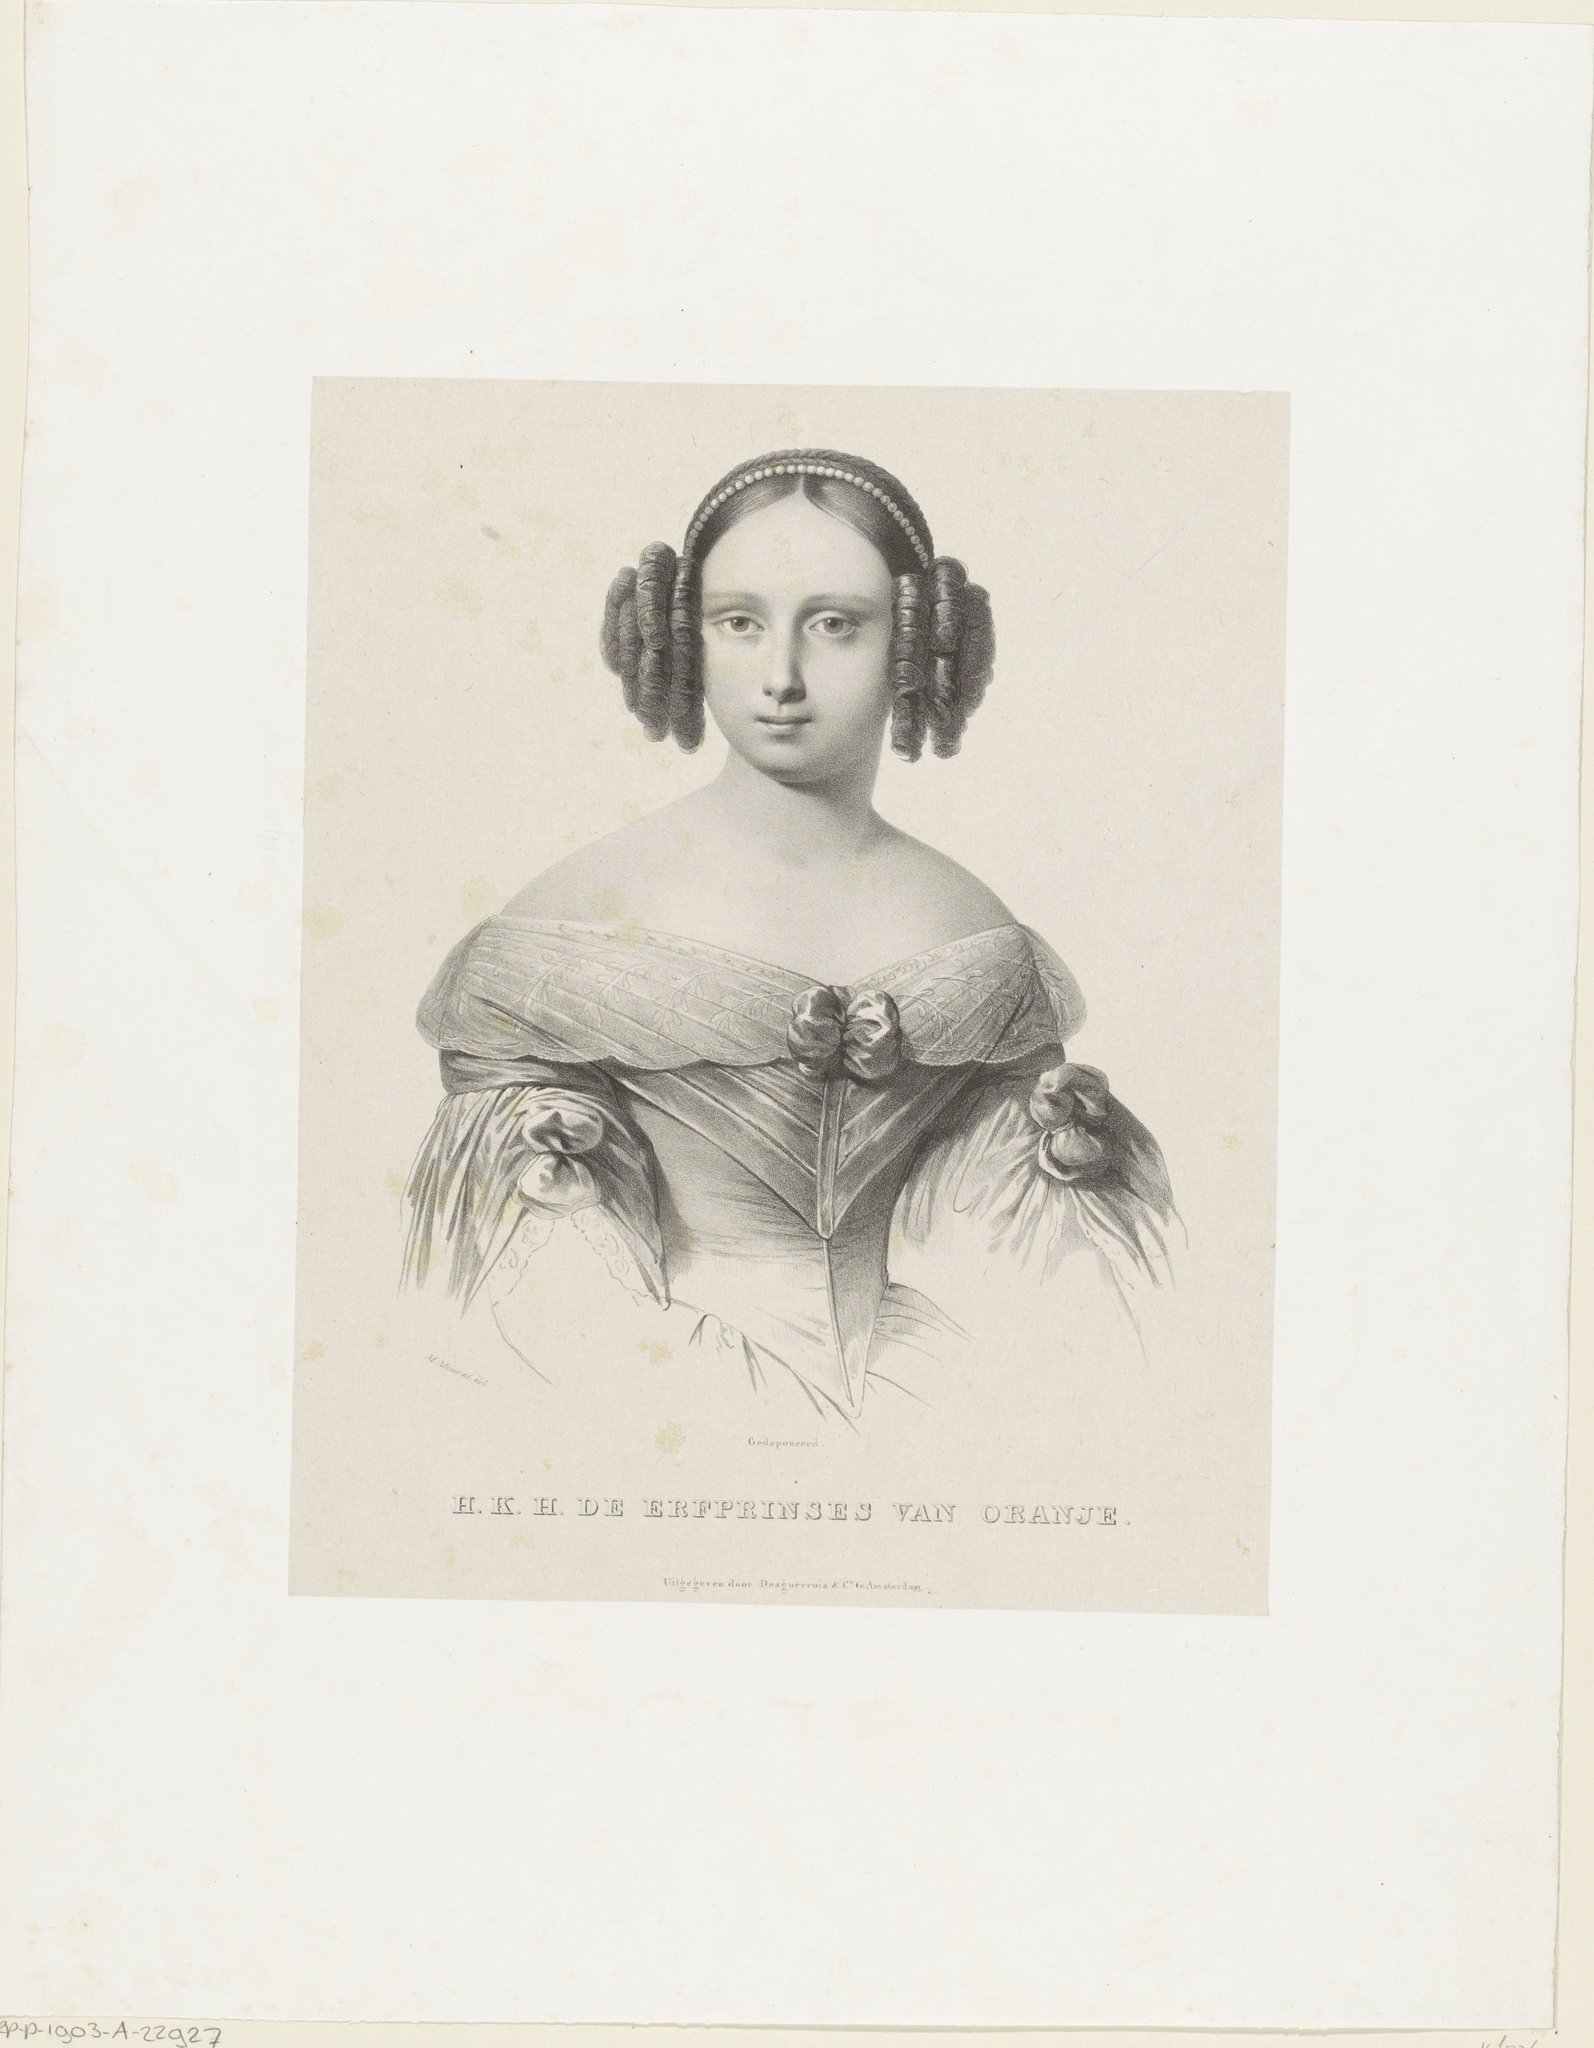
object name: print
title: Portret van Sophie van Württemberg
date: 1839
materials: paper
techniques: lithograph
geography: amsterdam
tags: the hague, sophia frederika mathilda van württemberg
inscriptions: collector's mark: Lugt 2166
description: Portret van Sophie. In de ondermarge haar titel.